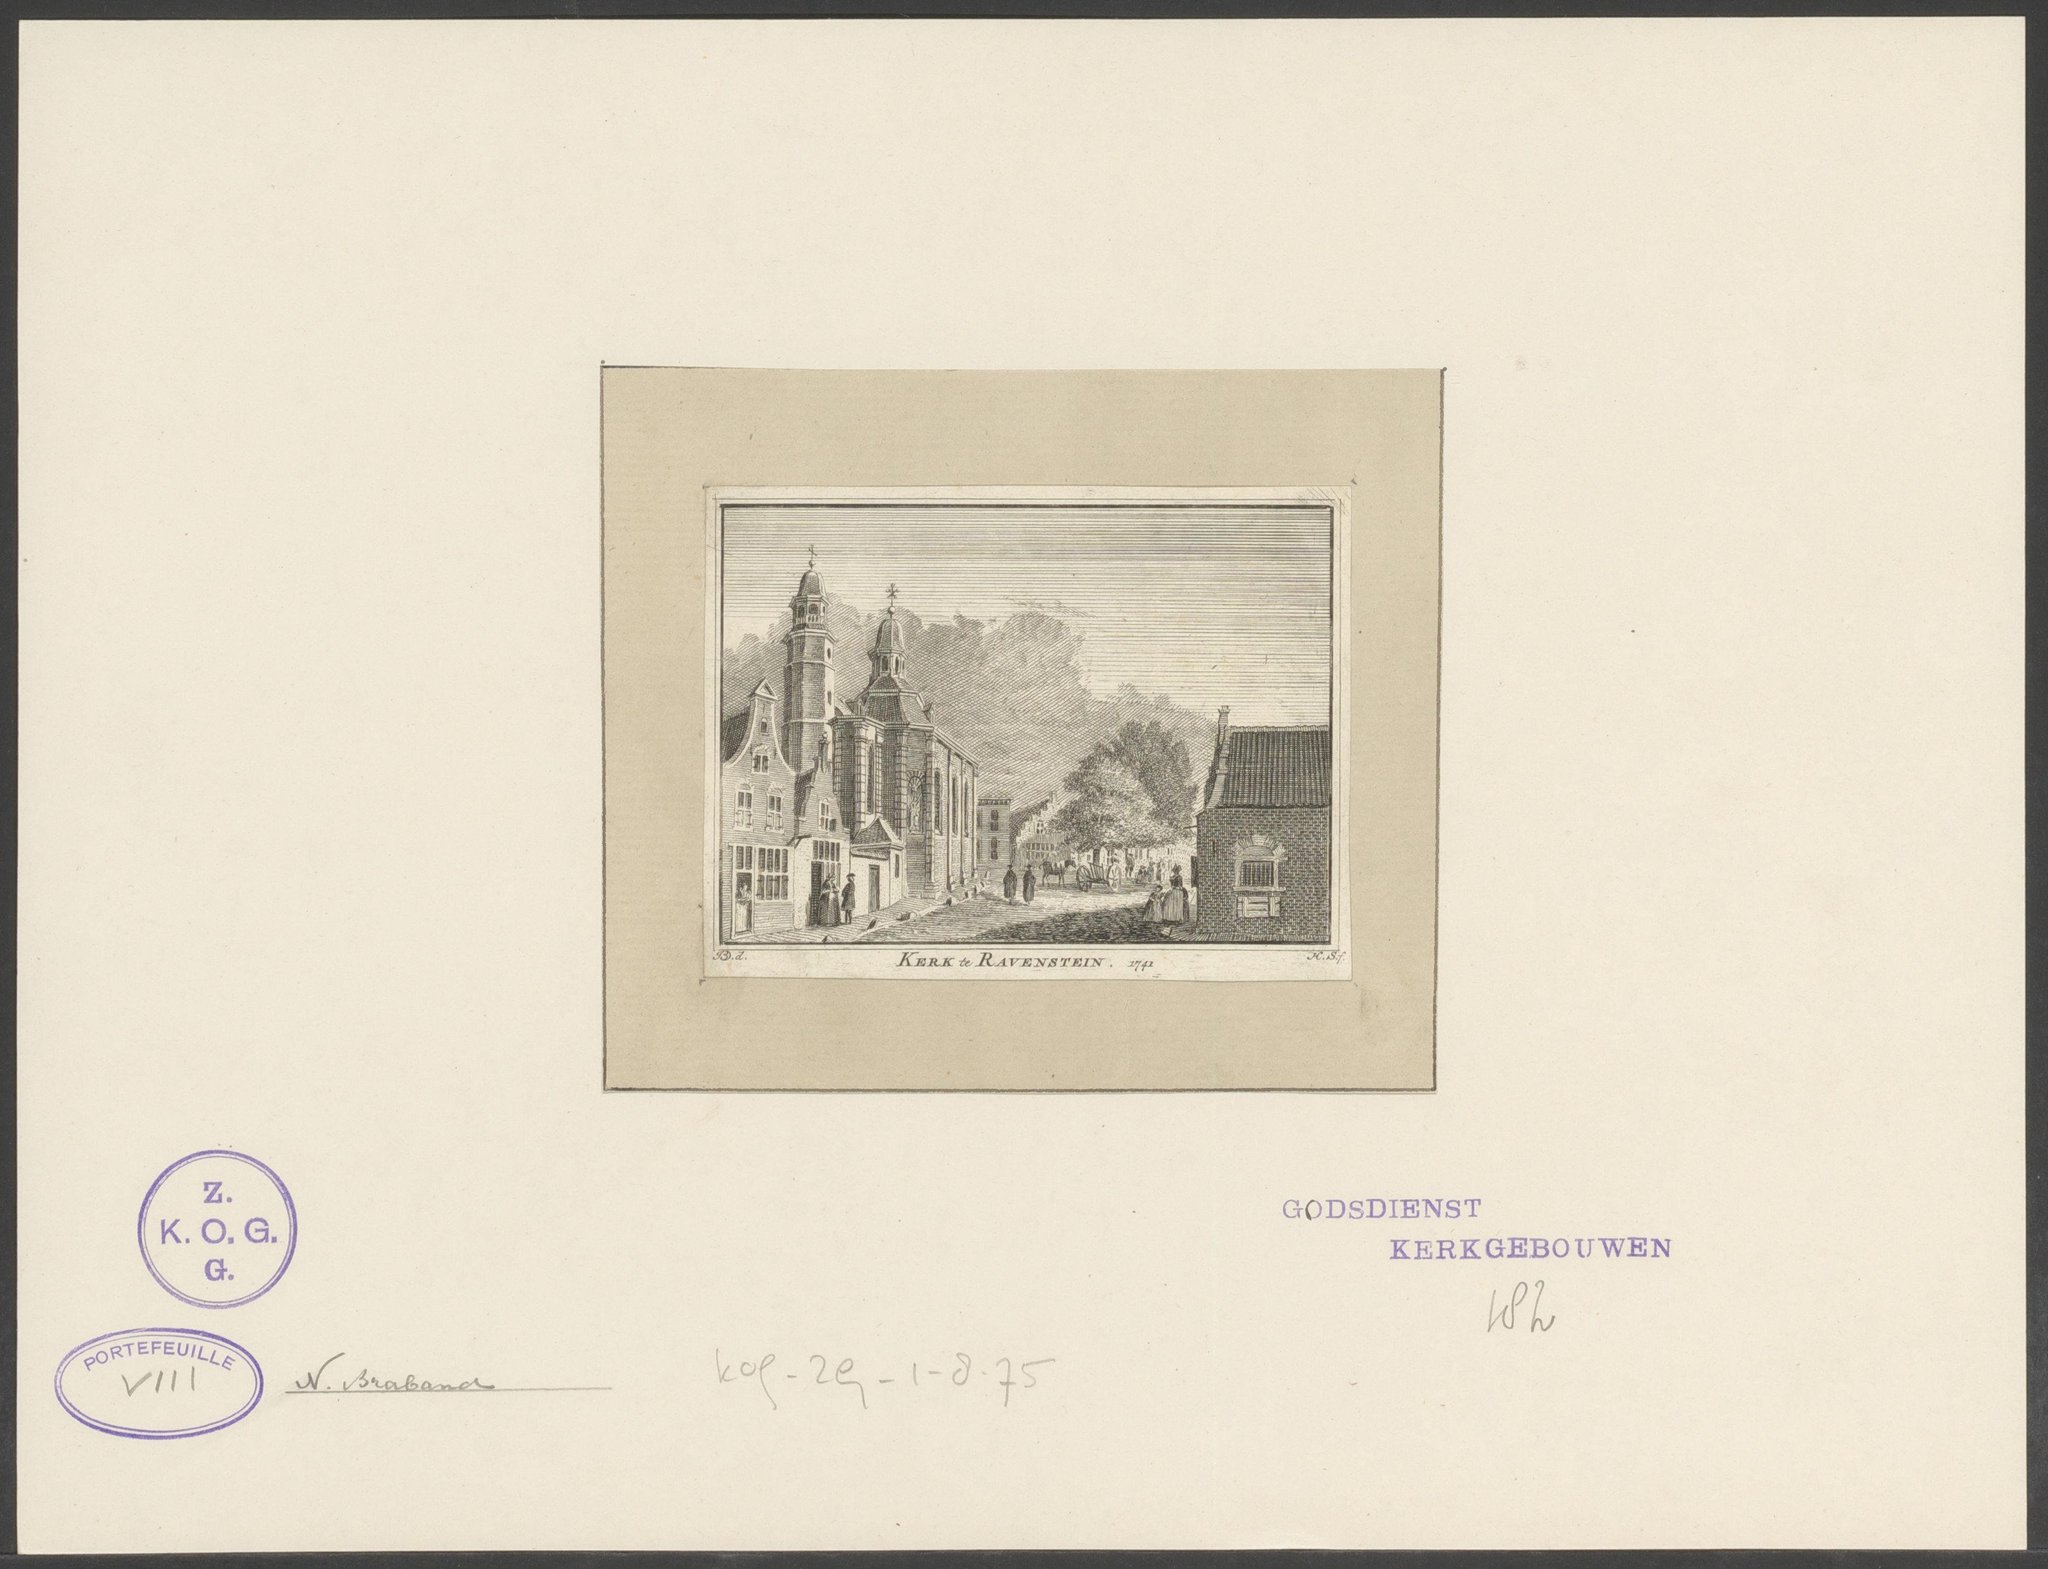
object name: book illustration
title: Gezicht op de kerk te Ravenstein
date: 1746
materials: paper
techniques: engraving, etching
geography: netherlands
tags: church (exterior), public road in village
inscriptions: collector's mark, collector's mark: Lugt 1641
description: Prent eerst gebruikt in: Het verheerlykt Nederland of kabinet van hedendaagsche gezigten van steden, dorpen (…). 9 delen. Amsterdam: Isaak Tirion en weduwe Isaak Tirion, 1745-1774, dl. 2 (1746). Later ook in: Nederlandsche tafereelen; of eene keurige verzameling van negen honderd fraaije gezigten van steden, dorpen, sloten, oudheden (….). 9 delen. Amsterdam: Jan de Groot, 1792, dl. 2.